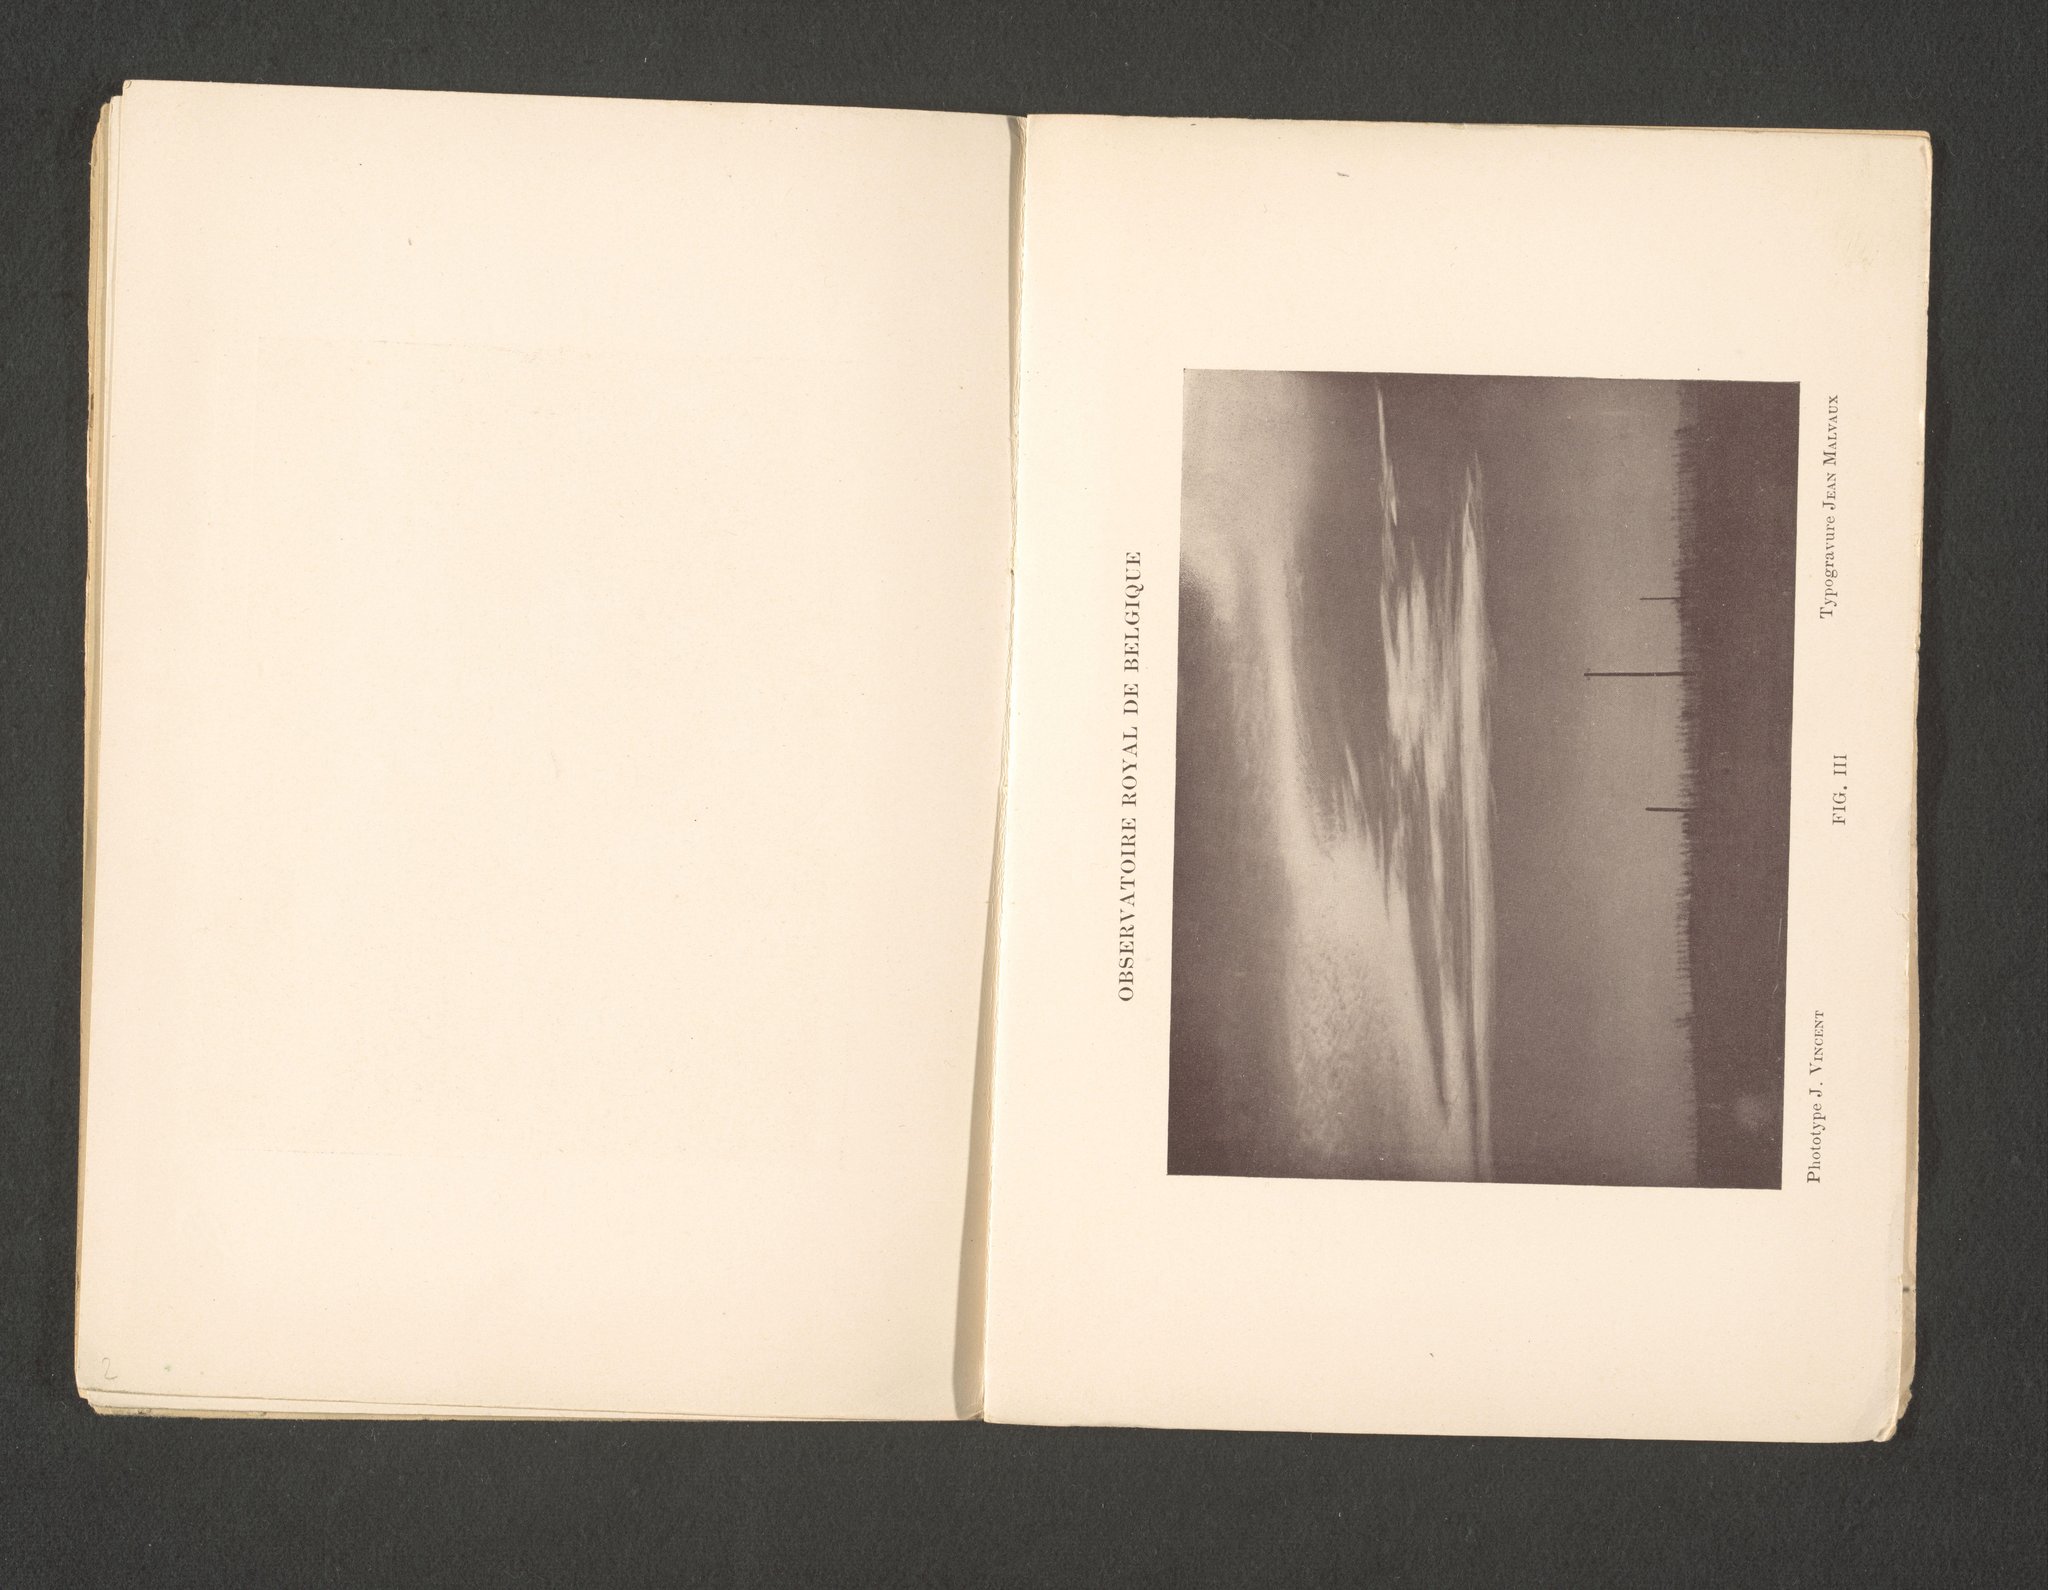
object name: page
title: Wolken gezien vanaf de Koninklijke Sterrenwacht van België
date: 1894-1899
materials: paper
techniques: autotype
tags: clouds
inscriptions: inscription: ‘FIG. III’